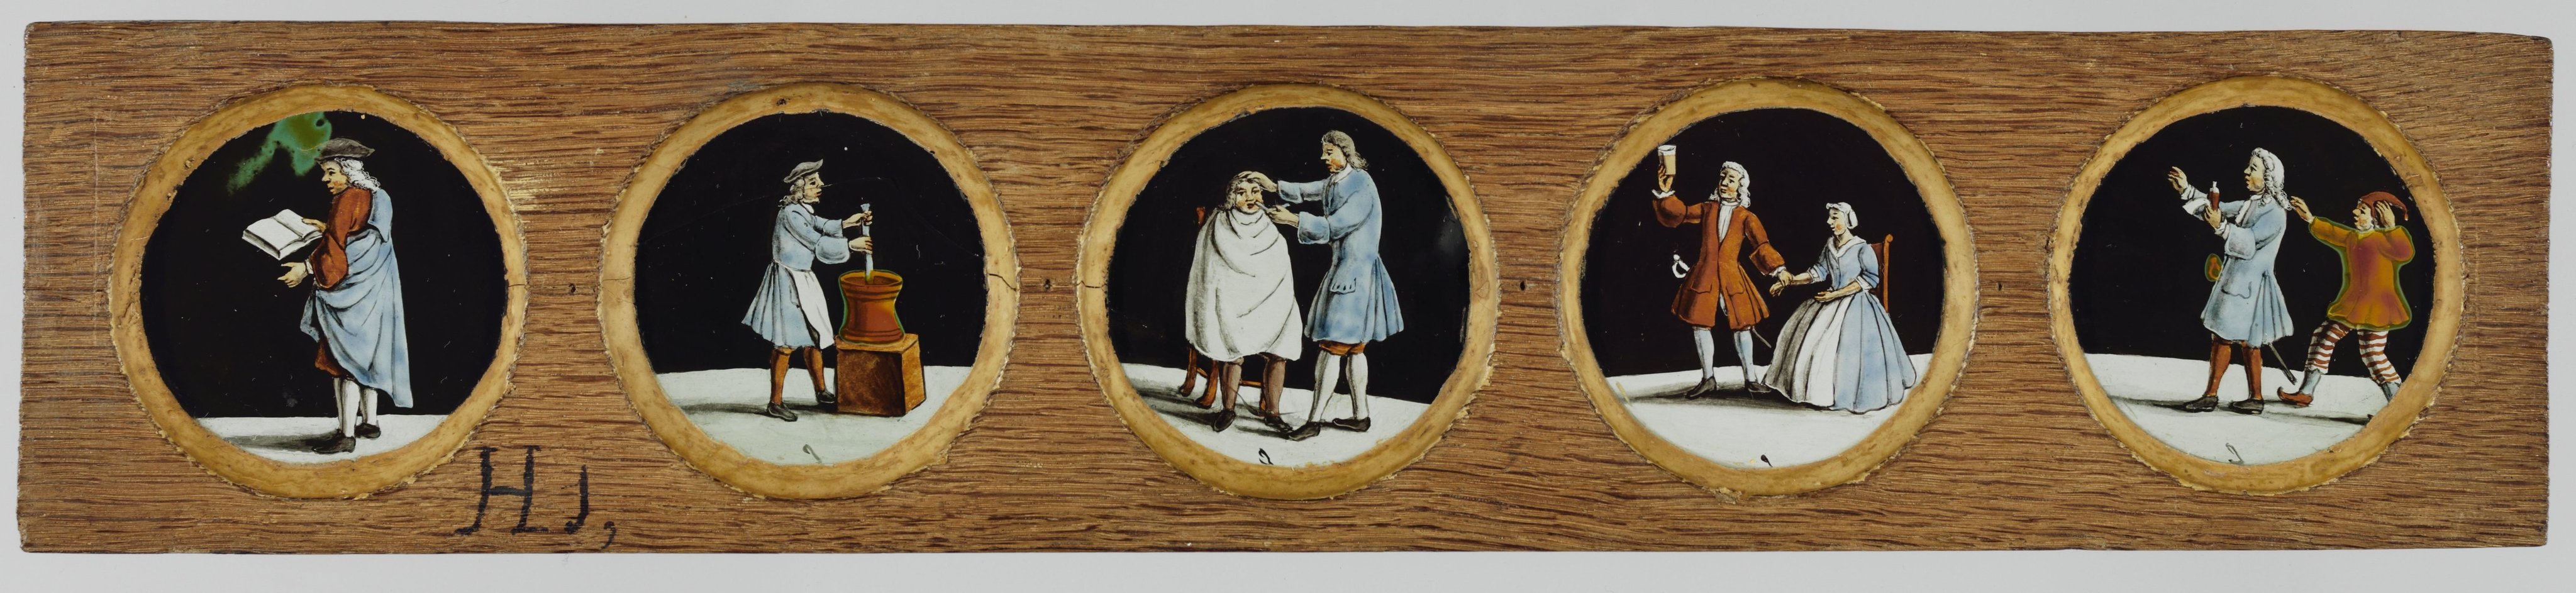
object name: lantern slide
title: Vijf bezigheden van dokters, apothekers en barbiers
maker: Anonymous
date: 1700-1790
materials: glass, wood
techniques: painted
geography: netherlands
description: Vijf glazen met afbeeldingen van het werk van dokters, apothekers en barbiers in een houten vatting.Het glas uiterst links: een man leest staande een boek. Het glas rechts daarvan: een man maalt iets met vijzel. Het middelste glas: een staande man scheert een andere man die zit en een wit laken voorgebonden heeft. Het glas rechts daarvan: een staande man houdt met zijn linkerhand de hand van een zittende vrouw vast, en heeft in zijn rechterhand een gevulde beker in de lucht. Het glas uiterst rechts: een lopende man, beide handen vooruitgestoken en in de linkerhand een onherkenbaar voorwerp, wordt gevolgd door een jongen.